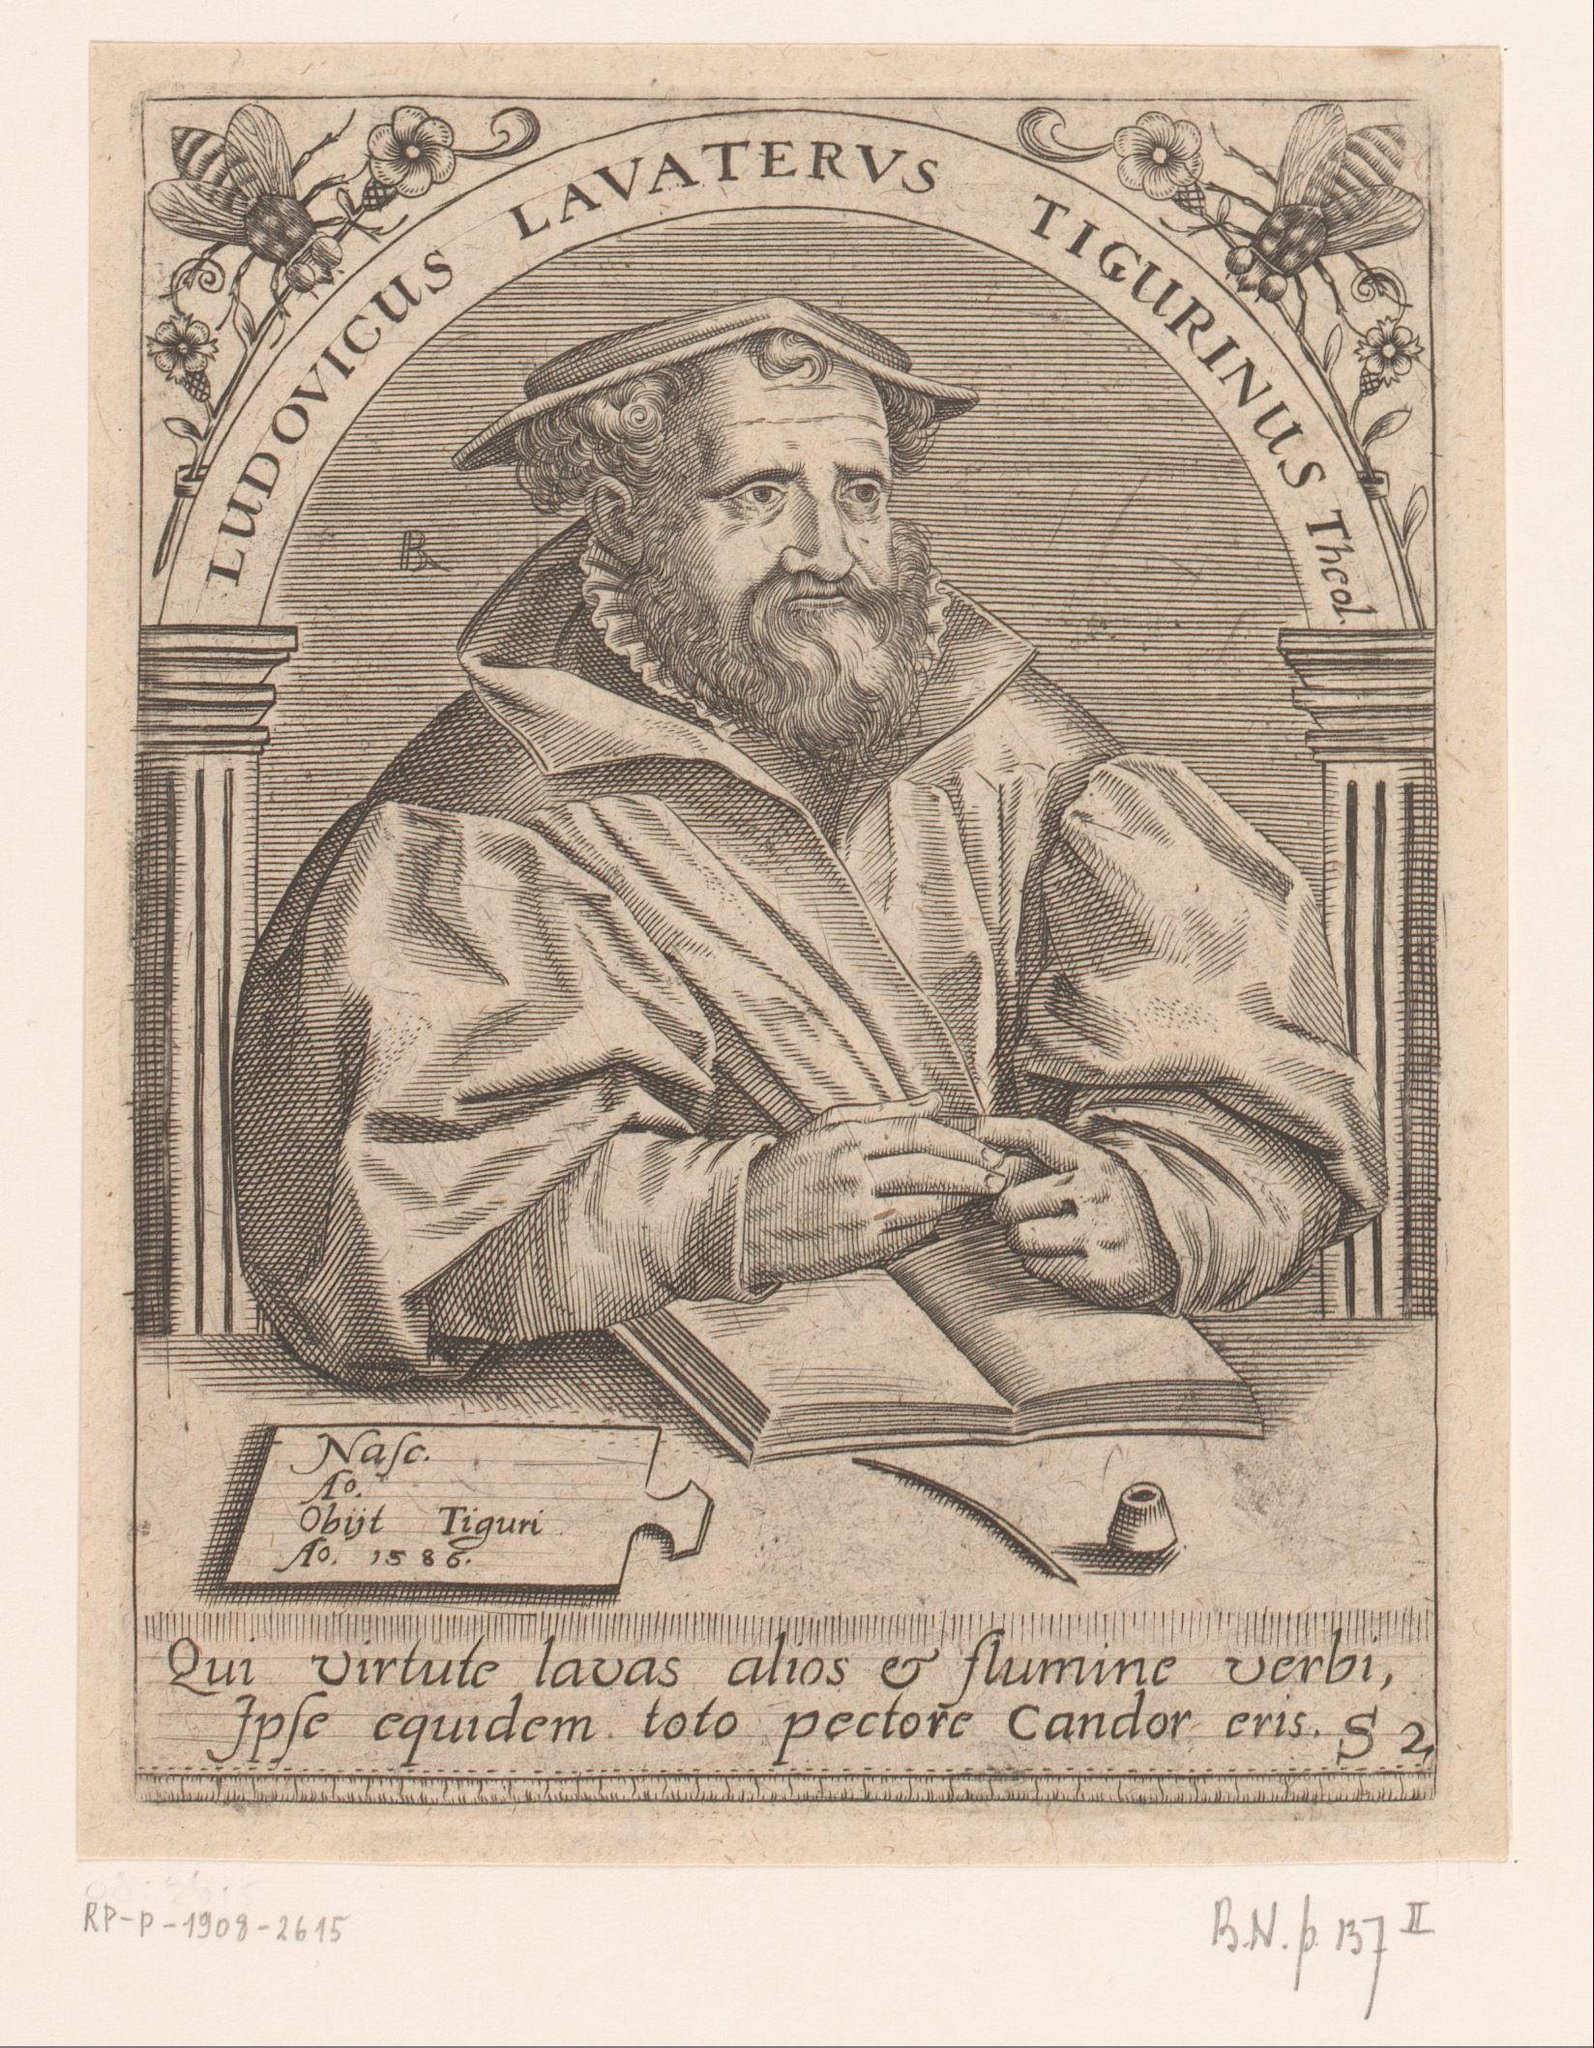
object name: print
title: Serie portretten van vijftiende- en zestiende-eeuwse geleerden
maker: robert boissard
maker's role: print maker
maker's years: 1570-1611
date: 1597-1599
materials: paper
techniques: engraving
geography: france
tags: ink-well, historical persons, armorial bearing, heraldry, insects: fly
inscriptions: collector's mark: Lugt 2228